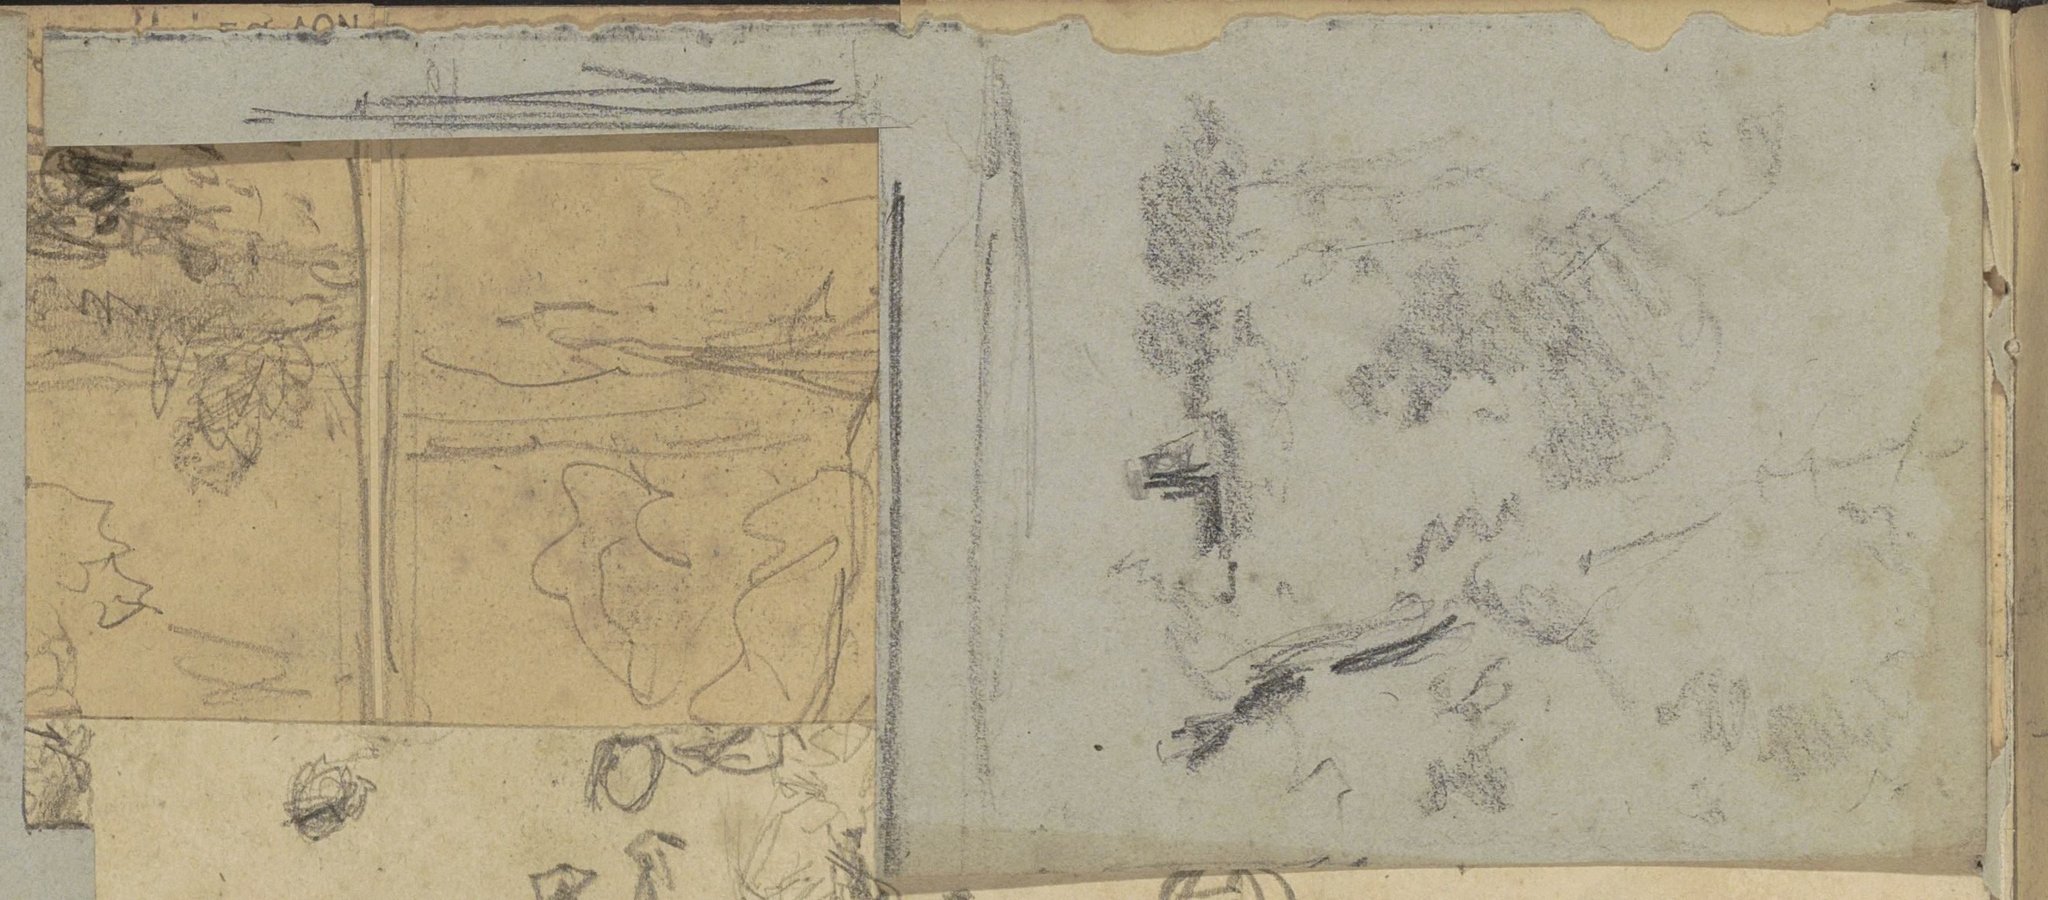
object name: sketchbook leaf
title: Studies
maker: willem roelofs (i)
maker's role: draughtsman, painter, print maker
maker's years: 1822-1897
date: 1846-1851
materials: paper, pencil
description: Verso van een losse tekening tussen blad 19 en 20 uit een schetsboek met 25 bladen.